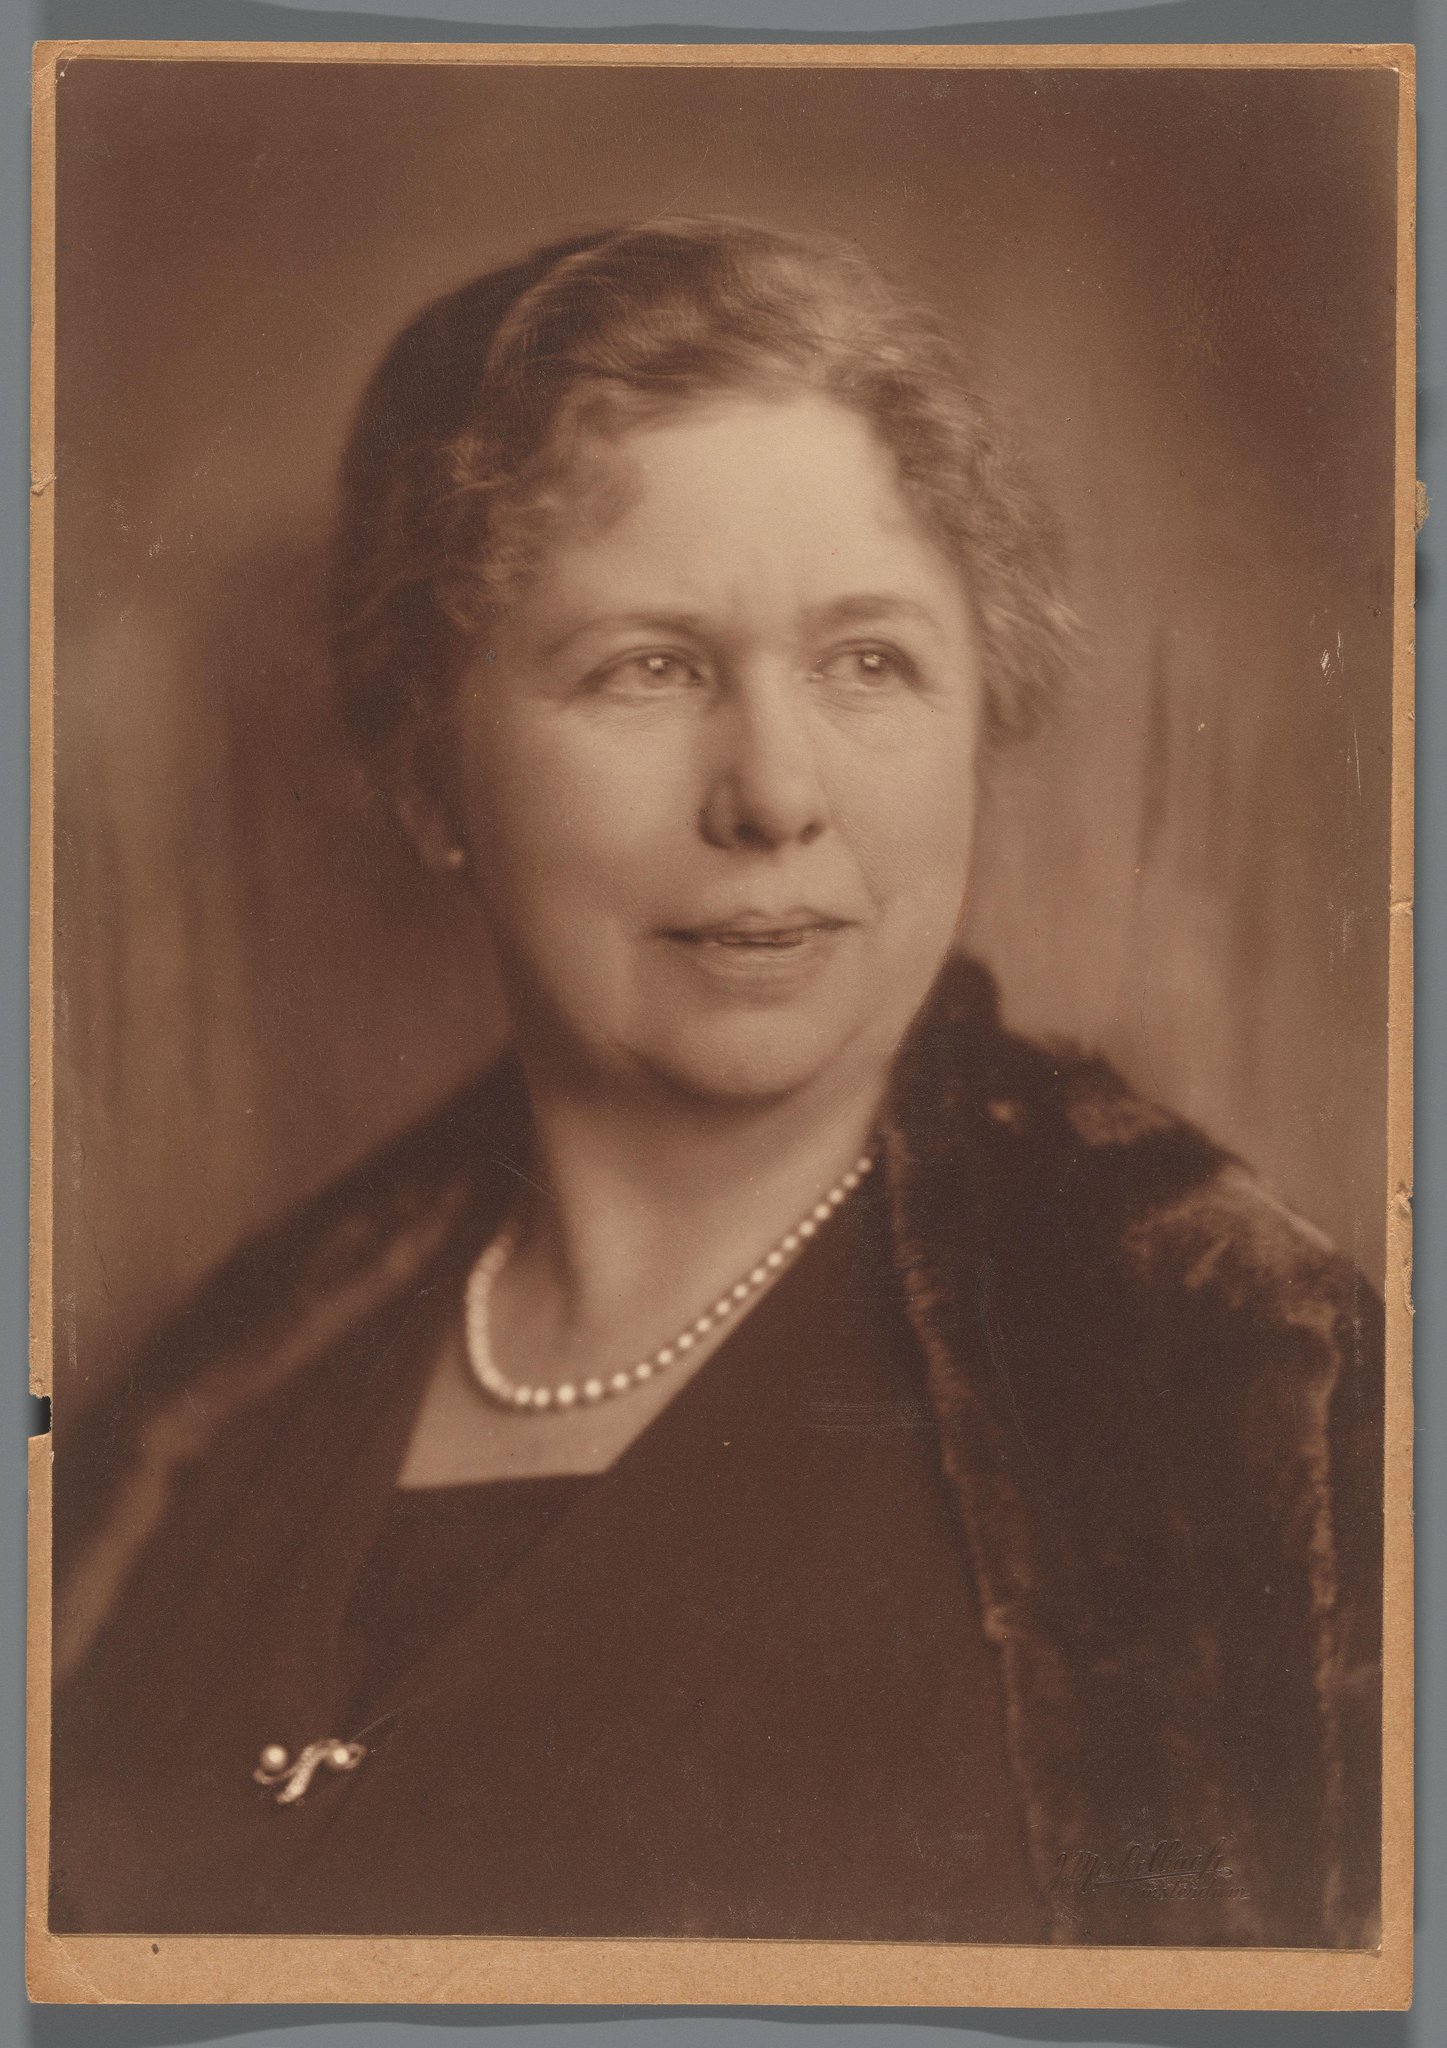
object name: photograph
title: Portret van Poppy Dunlop met parelketting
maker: Anonymous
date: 1900-1940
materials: cardboard, photographic support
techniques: albumen print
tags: carolina johanna theofanie bernardine van den berg-dunlop (poppy)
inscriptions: inscription: ‘Poppy’